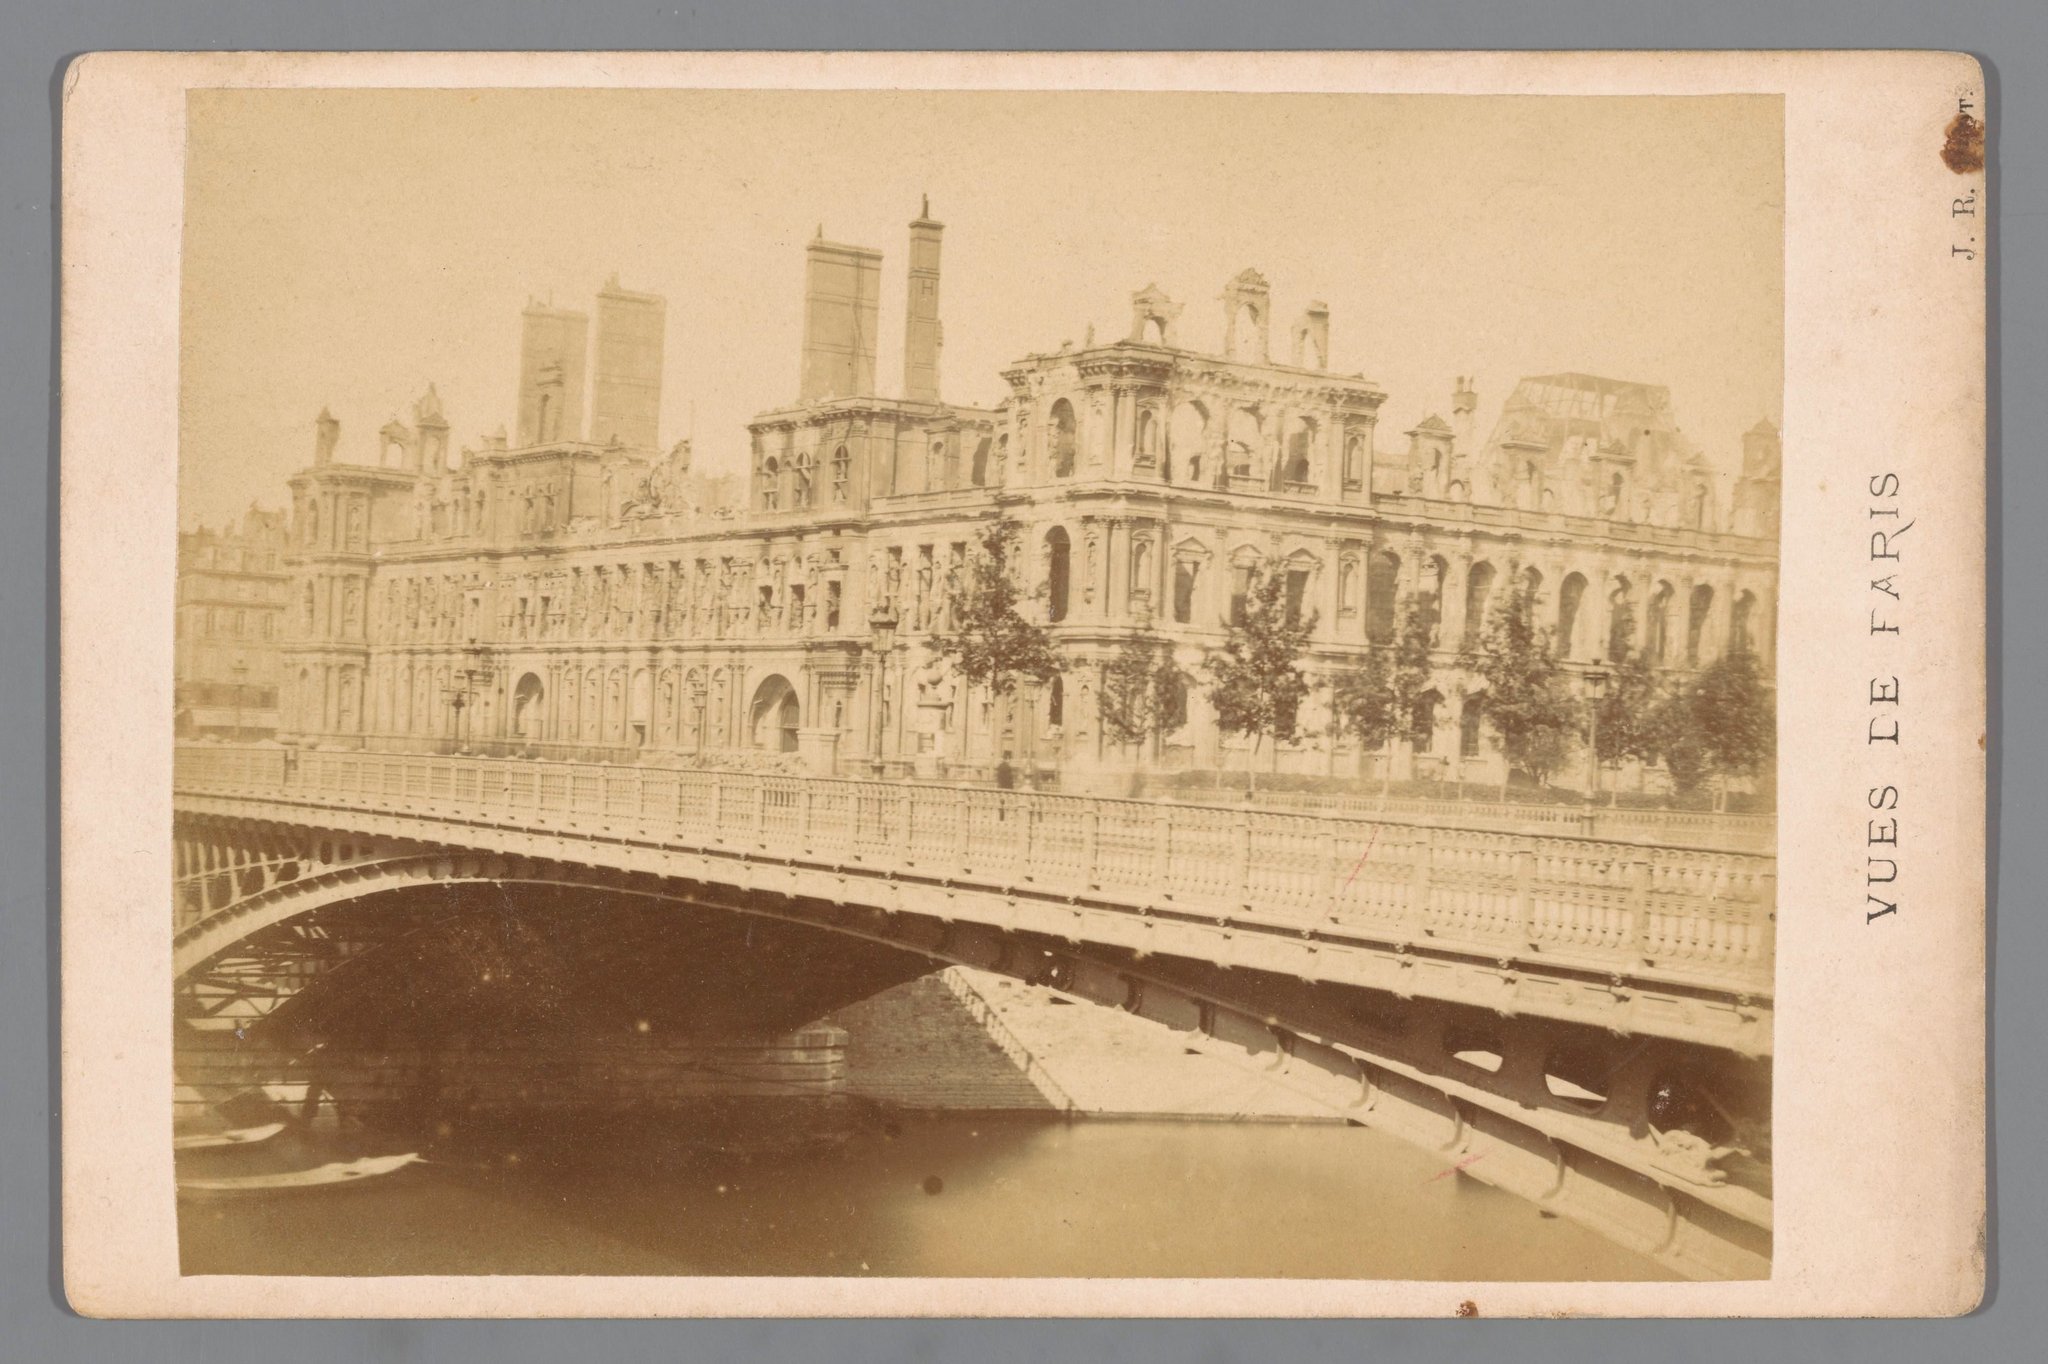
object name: photograph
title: Gezicht op het stadhuis in Parijs na de brand door de Commune van Parijs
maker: jr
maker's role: fotograaf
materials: cardboard, photographic support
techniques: albumen print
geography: paris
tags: ruin of a building ~ architecture, townhall, bridge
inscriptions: annotation: ‘Hotel de ville’